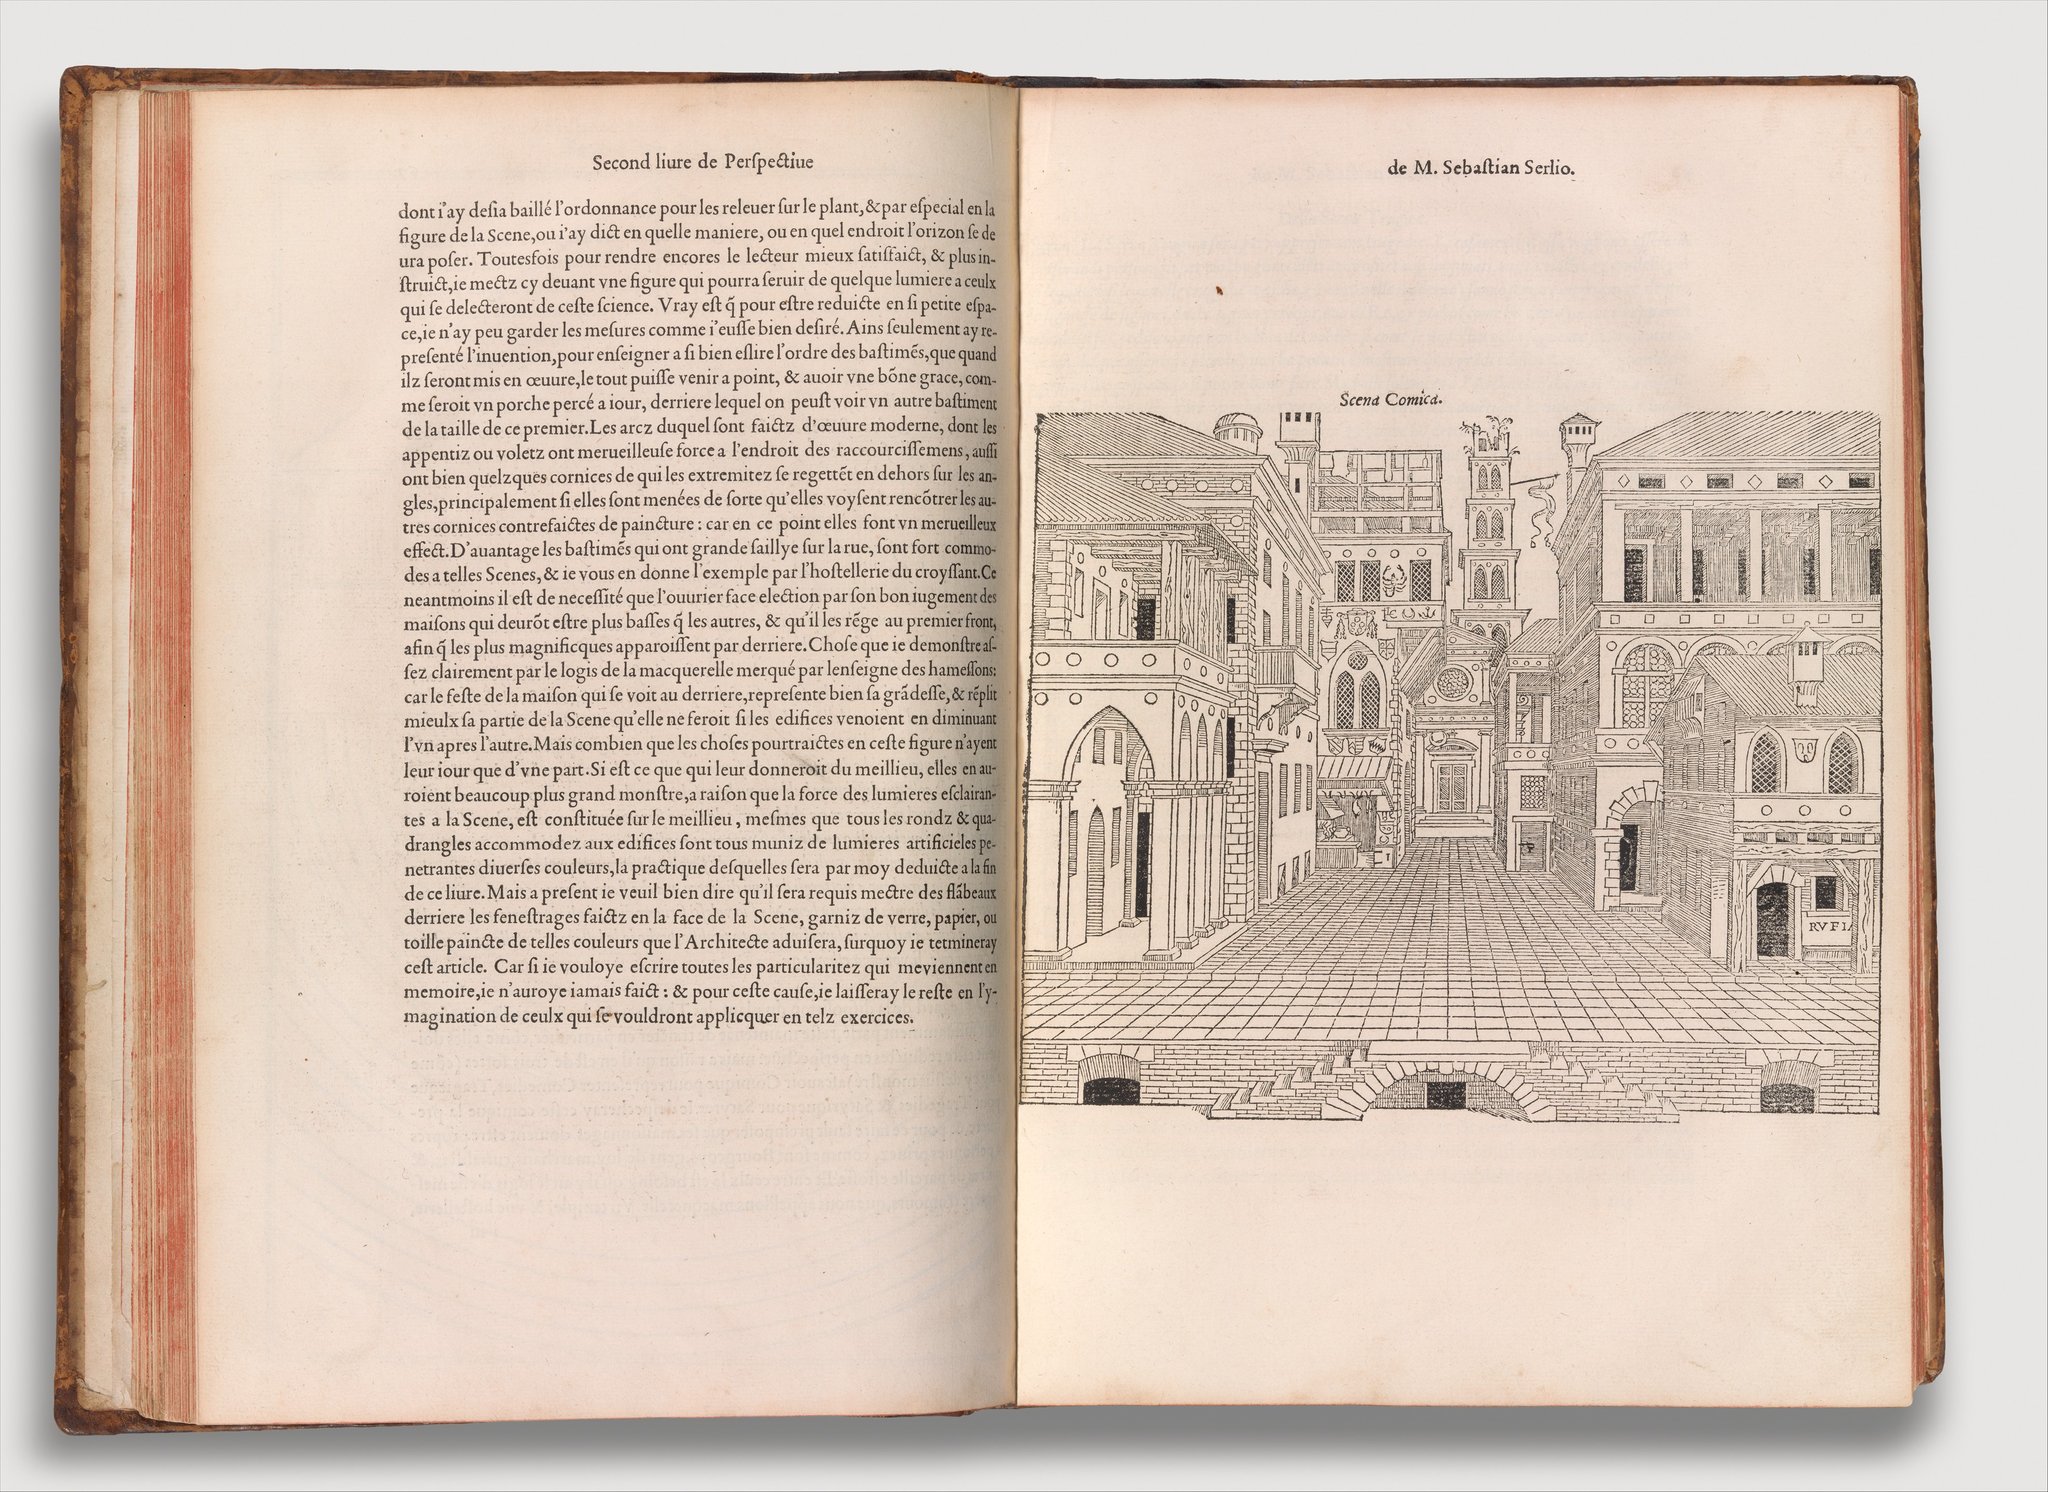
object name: book print ornament architecture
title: Compendium of Architectural Books by Sebastiano Serlio (Books I-V)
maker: sebastiano serlio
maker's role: author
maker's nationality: italian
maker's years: 1475-1554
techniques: printing, woodcut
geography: france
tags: architecture